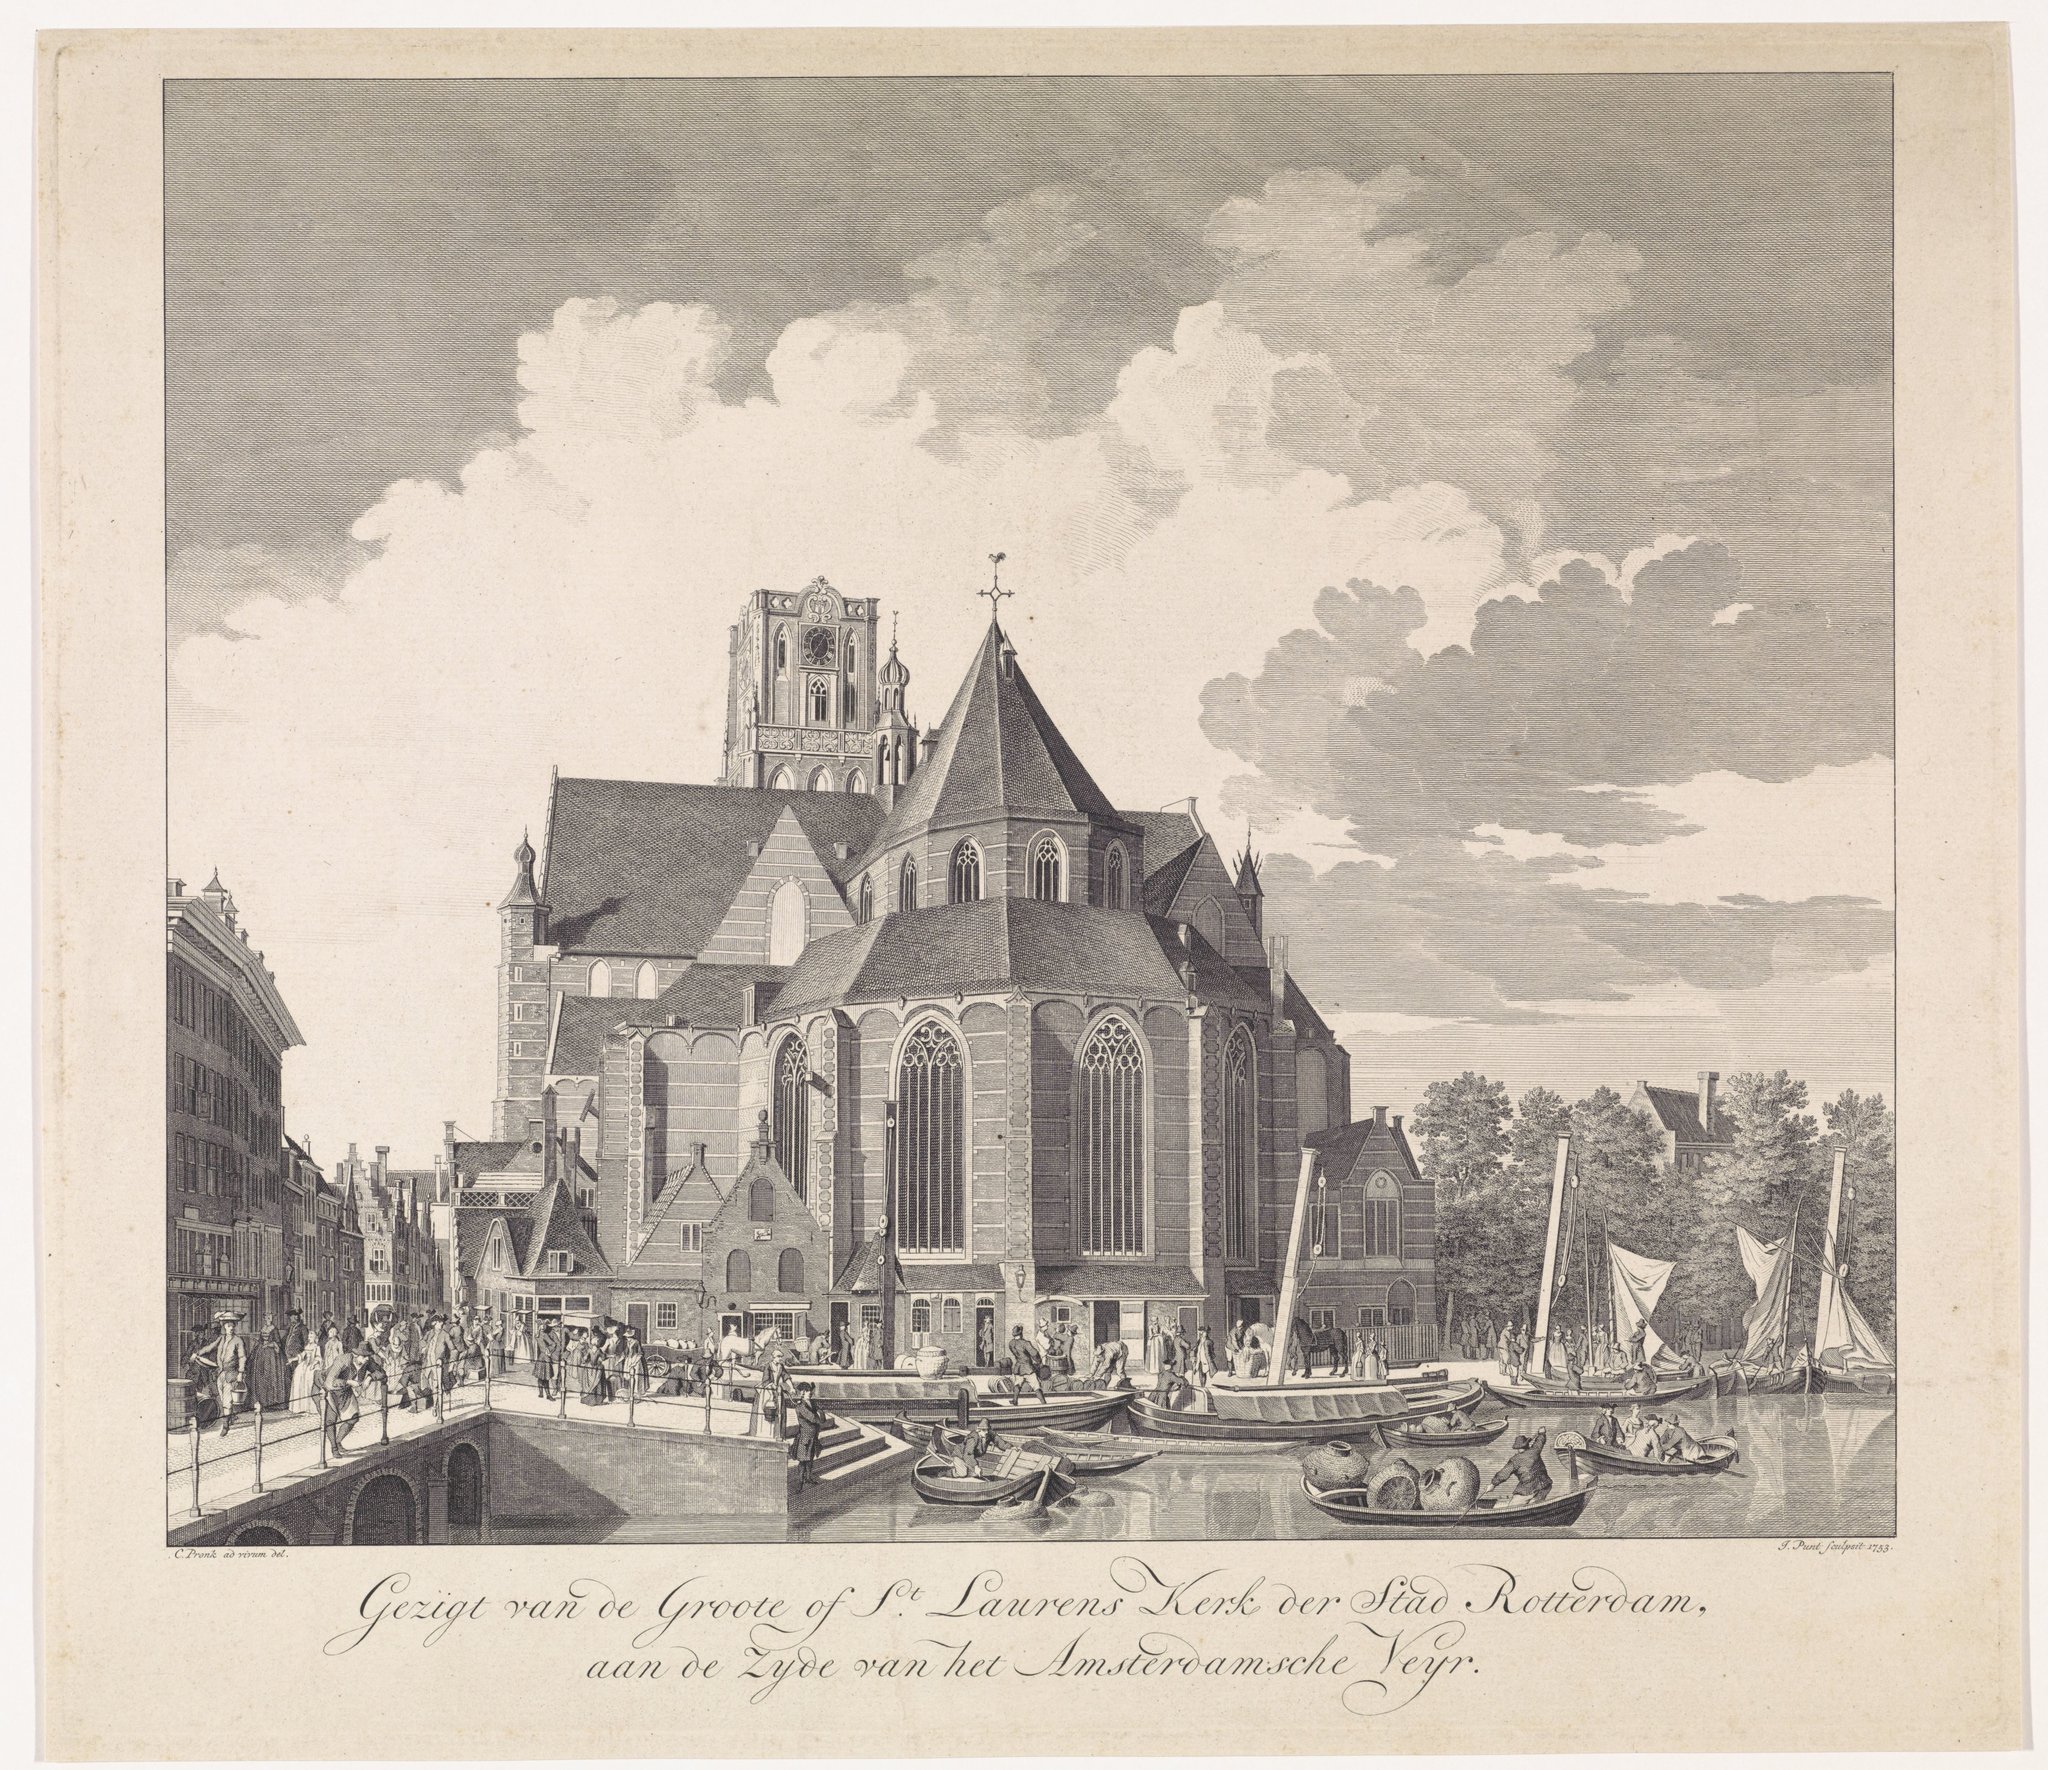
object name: print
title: Gezigt van de Groote of St. Laurens Kerk der stad Rotterdam, aan de zyde van het Amsterdamsche Veyr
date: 1753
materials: paper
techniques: engraving, etching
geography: amsterdam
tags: church (exterior)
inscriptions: collector's mark: Lugt 2228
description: Gezicht op de achterkant van de Grote of Sint-Laurenskerk te Rotterdam, gezien vanaf de Binnenrotte.